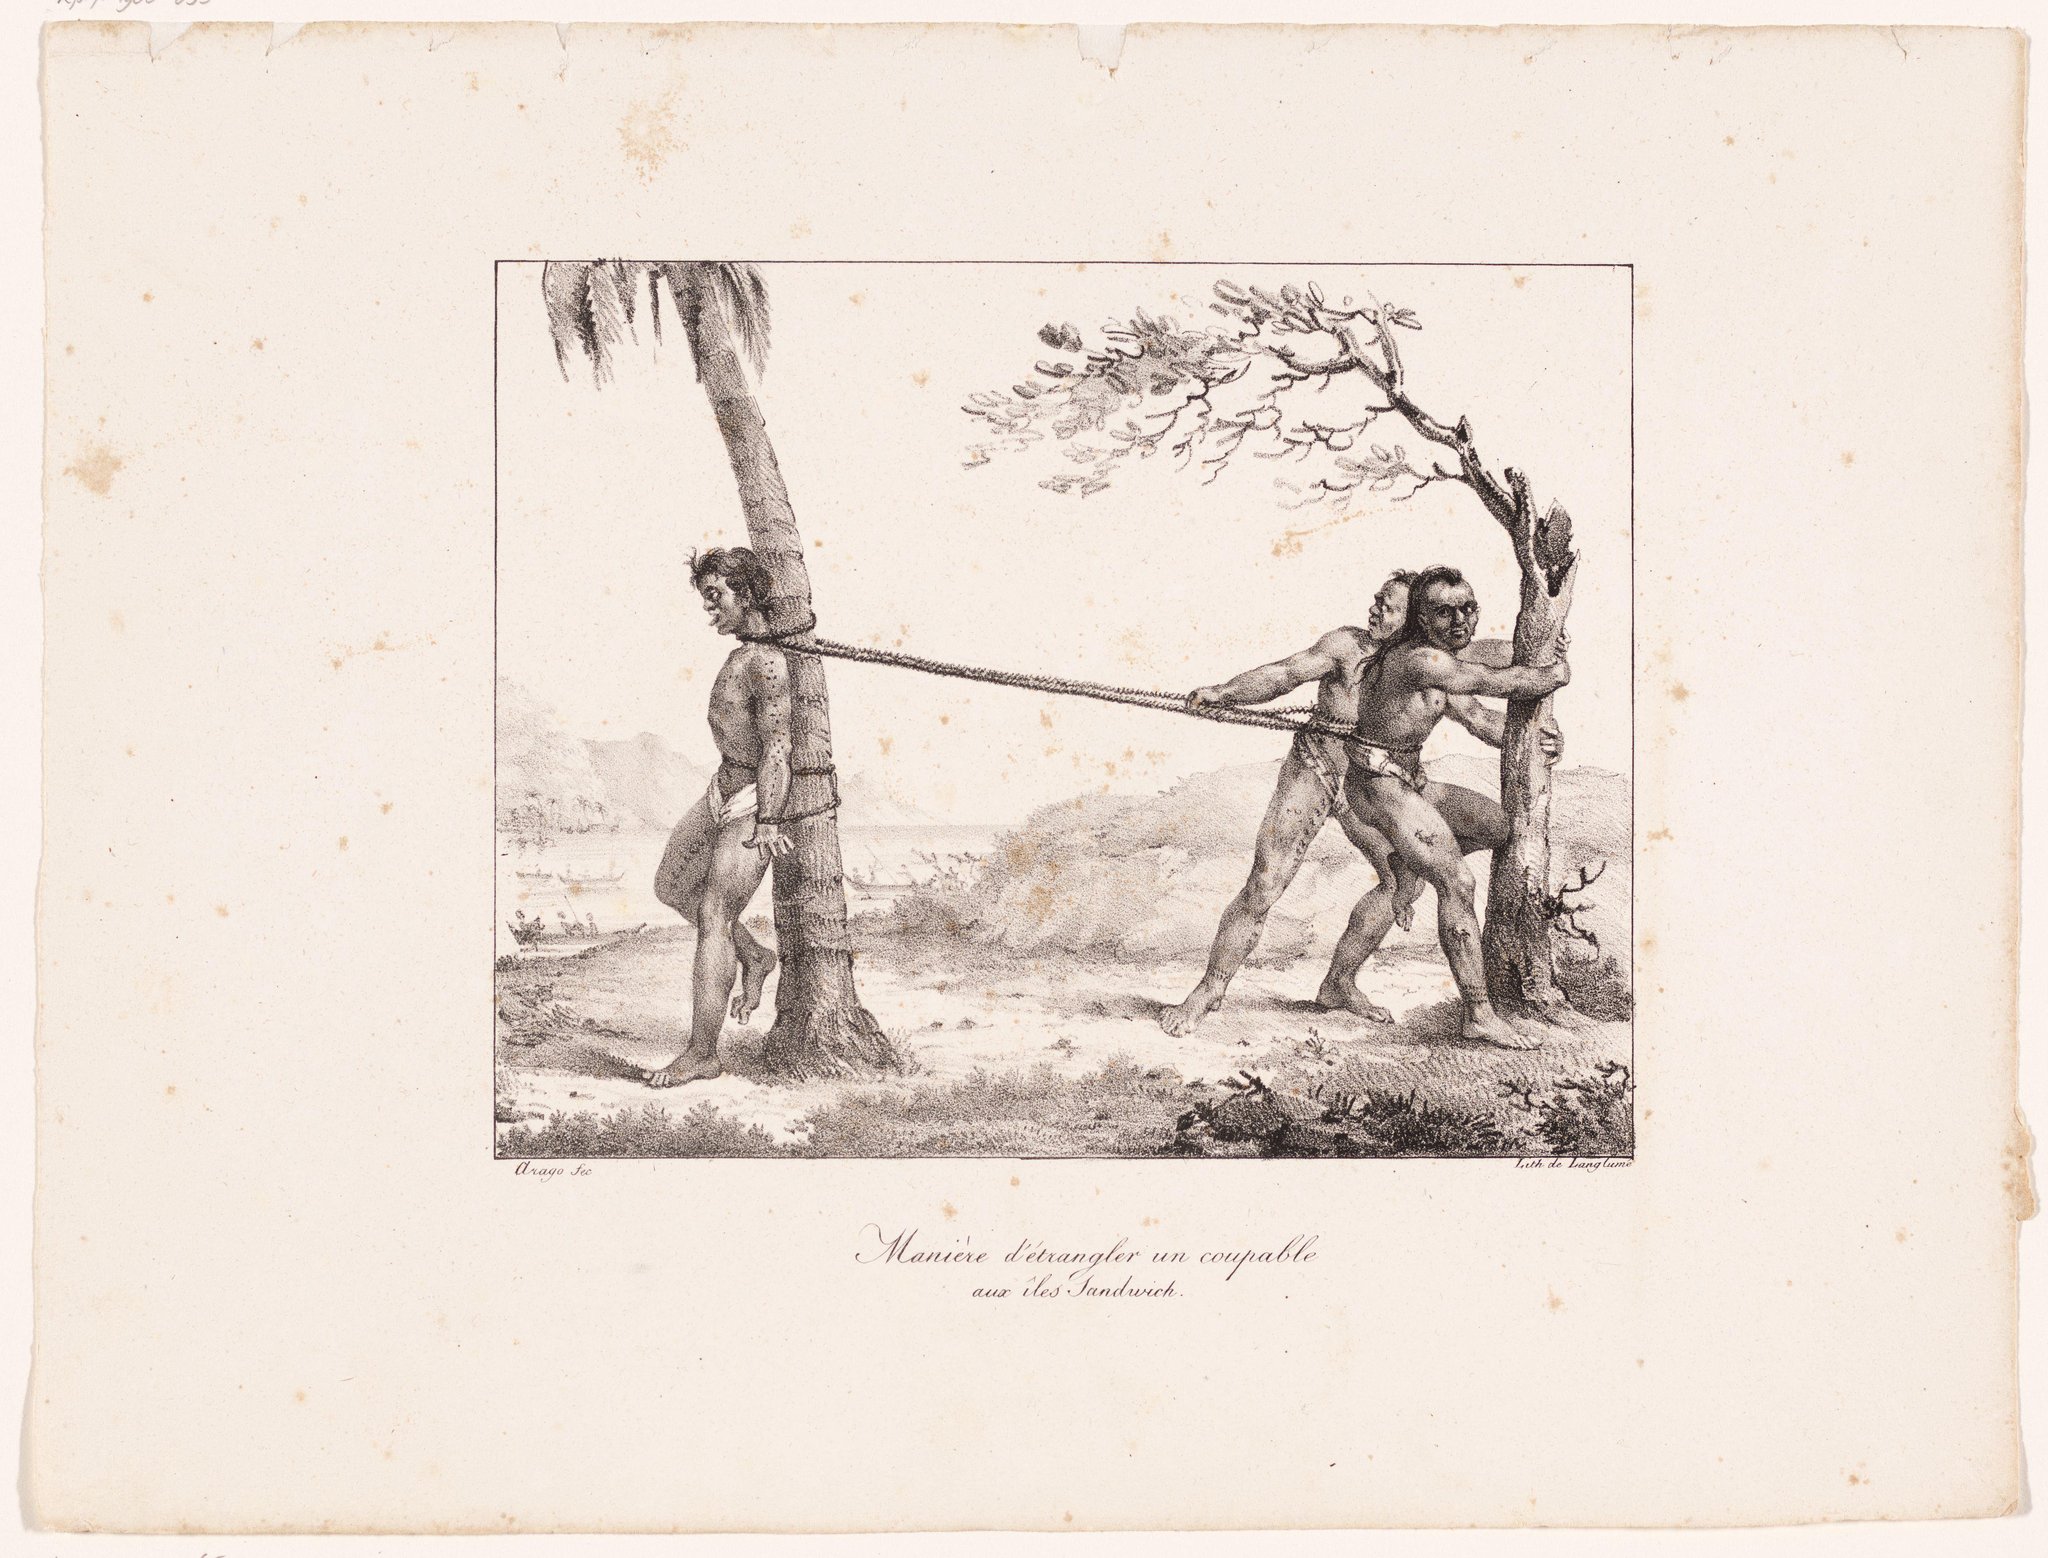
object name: book illustration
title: Manière d'étrangler un coupable aux îles Sandwich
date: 1822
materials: paper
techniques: lithograph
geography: paris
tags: death penalty, execution, violent death by strangling, australian and oceanian races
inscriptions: collector's mark: Lugt 2228a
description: Prent mogelijk uit een album dat is uitgegeven bij: Arago, J.E.V. Promenade autour de monde pendant les années 1817, 1818, 1819 et 1820, sur les corvettes du roi l'Uranie et la Physicienne, commandées par M. Freycinet. 2 dln. Parijs: Leblanc, 1822.